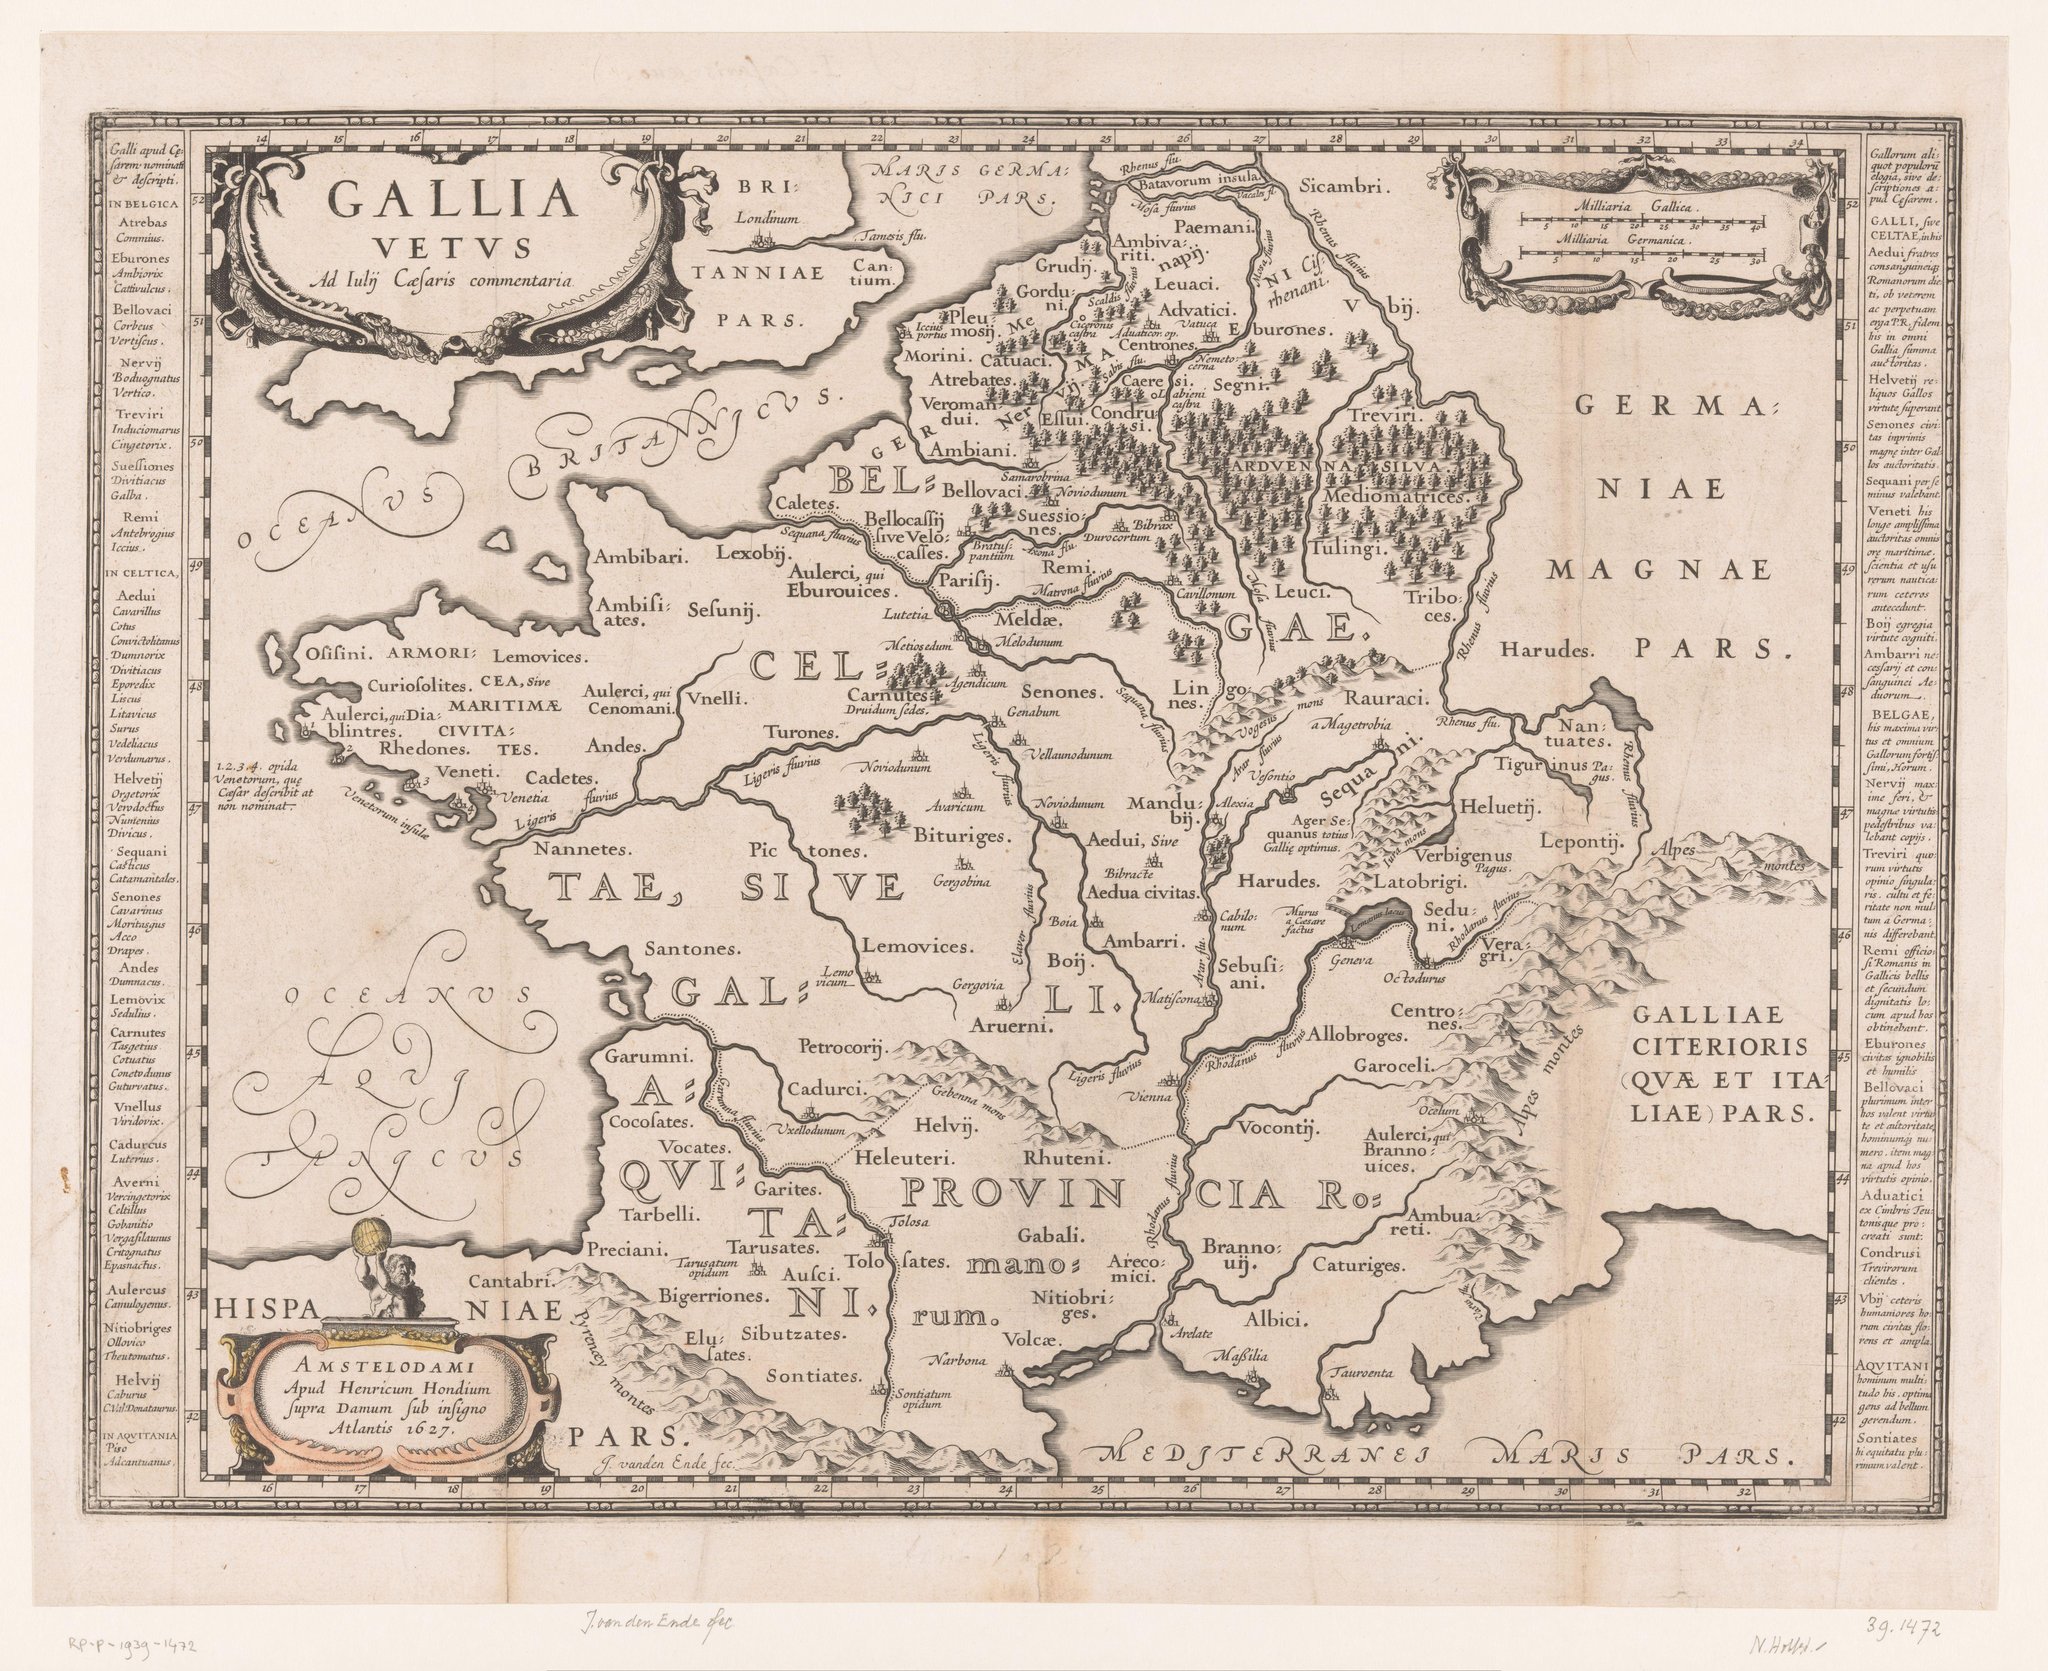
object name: print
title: Kaart van het oude Gallië, 1627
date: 1627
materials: paper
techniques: engraving, etching, hand coloring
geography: amsterdam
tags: maps of separate countries or regions, france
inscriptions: collector's mark: Lugt 2760, collector's mark: Lugt 2166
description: Kaart van het oude Gallië. Linksboven staat een cartouche met de titel: 'Gallia vetus'. Rechtsboven twee schaalstokken in een cartouche. Rondom een gradenverdeling.